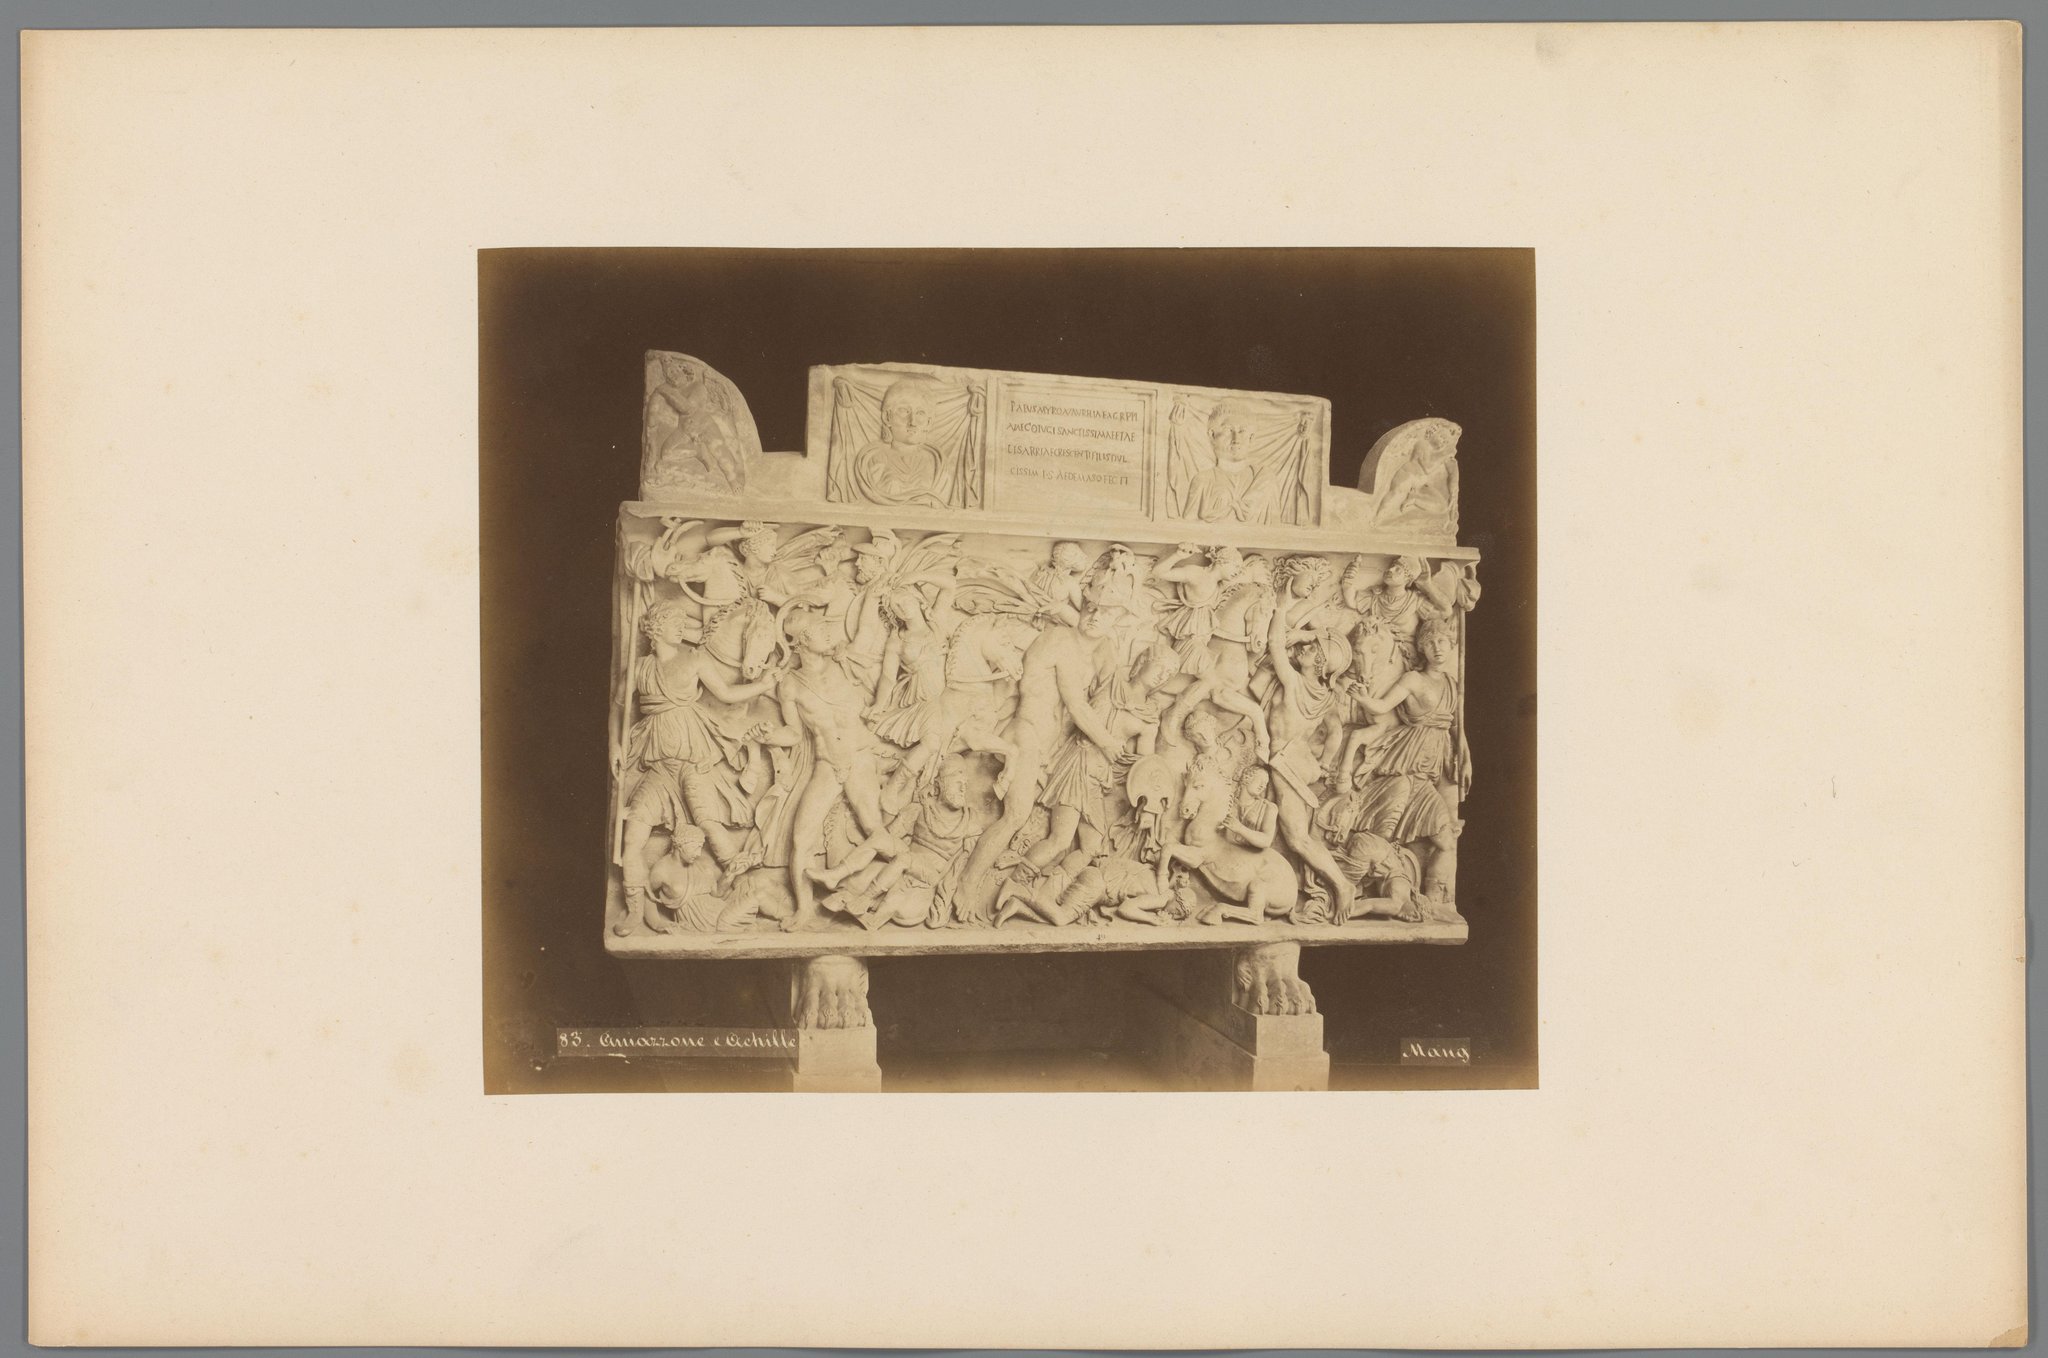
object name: photograph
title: Amazzone e Achille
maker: michèle mang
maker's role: fotograaf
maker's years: 1840-1909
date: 1863-1887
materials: cardboard, paper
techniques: albumen print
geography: vatican city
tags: battle of amazons; amazonomachy, sarcophagus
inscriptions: number: ‘83.’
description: Het deksel van de sarcofaag dat op de foto te zien is hoorde oorspronkelijk niet bij de sarcofaag.